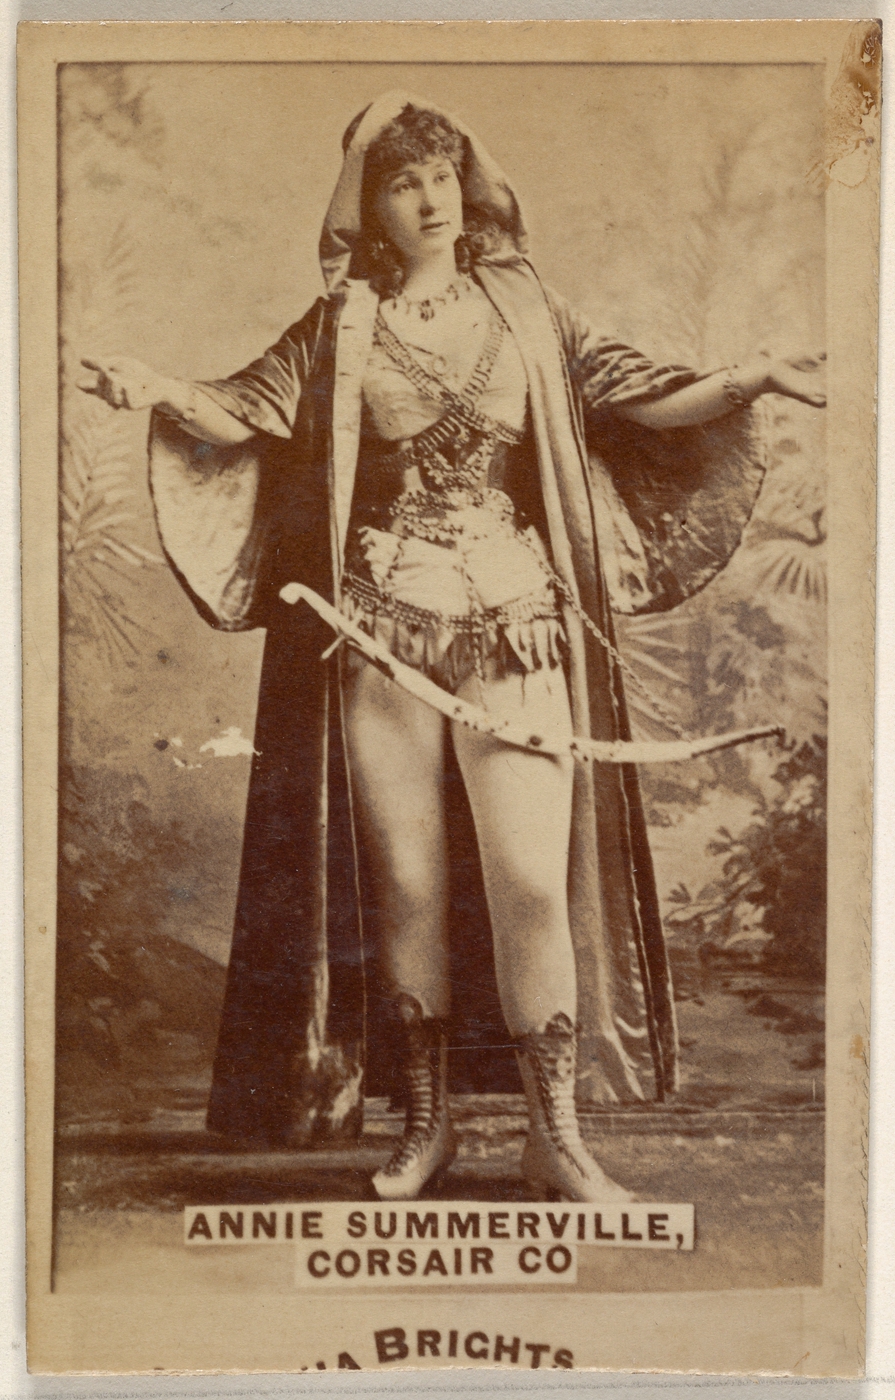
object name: photograph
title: Annie Summerville, Corsair Co., from the Actors and Actresses series (N45, Type 6) for Virginia Brights Cigarettes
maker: allen & ginter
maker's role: publisher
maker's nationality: american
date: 1888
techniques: albumen silver print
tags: swords,portraits,women,actresses